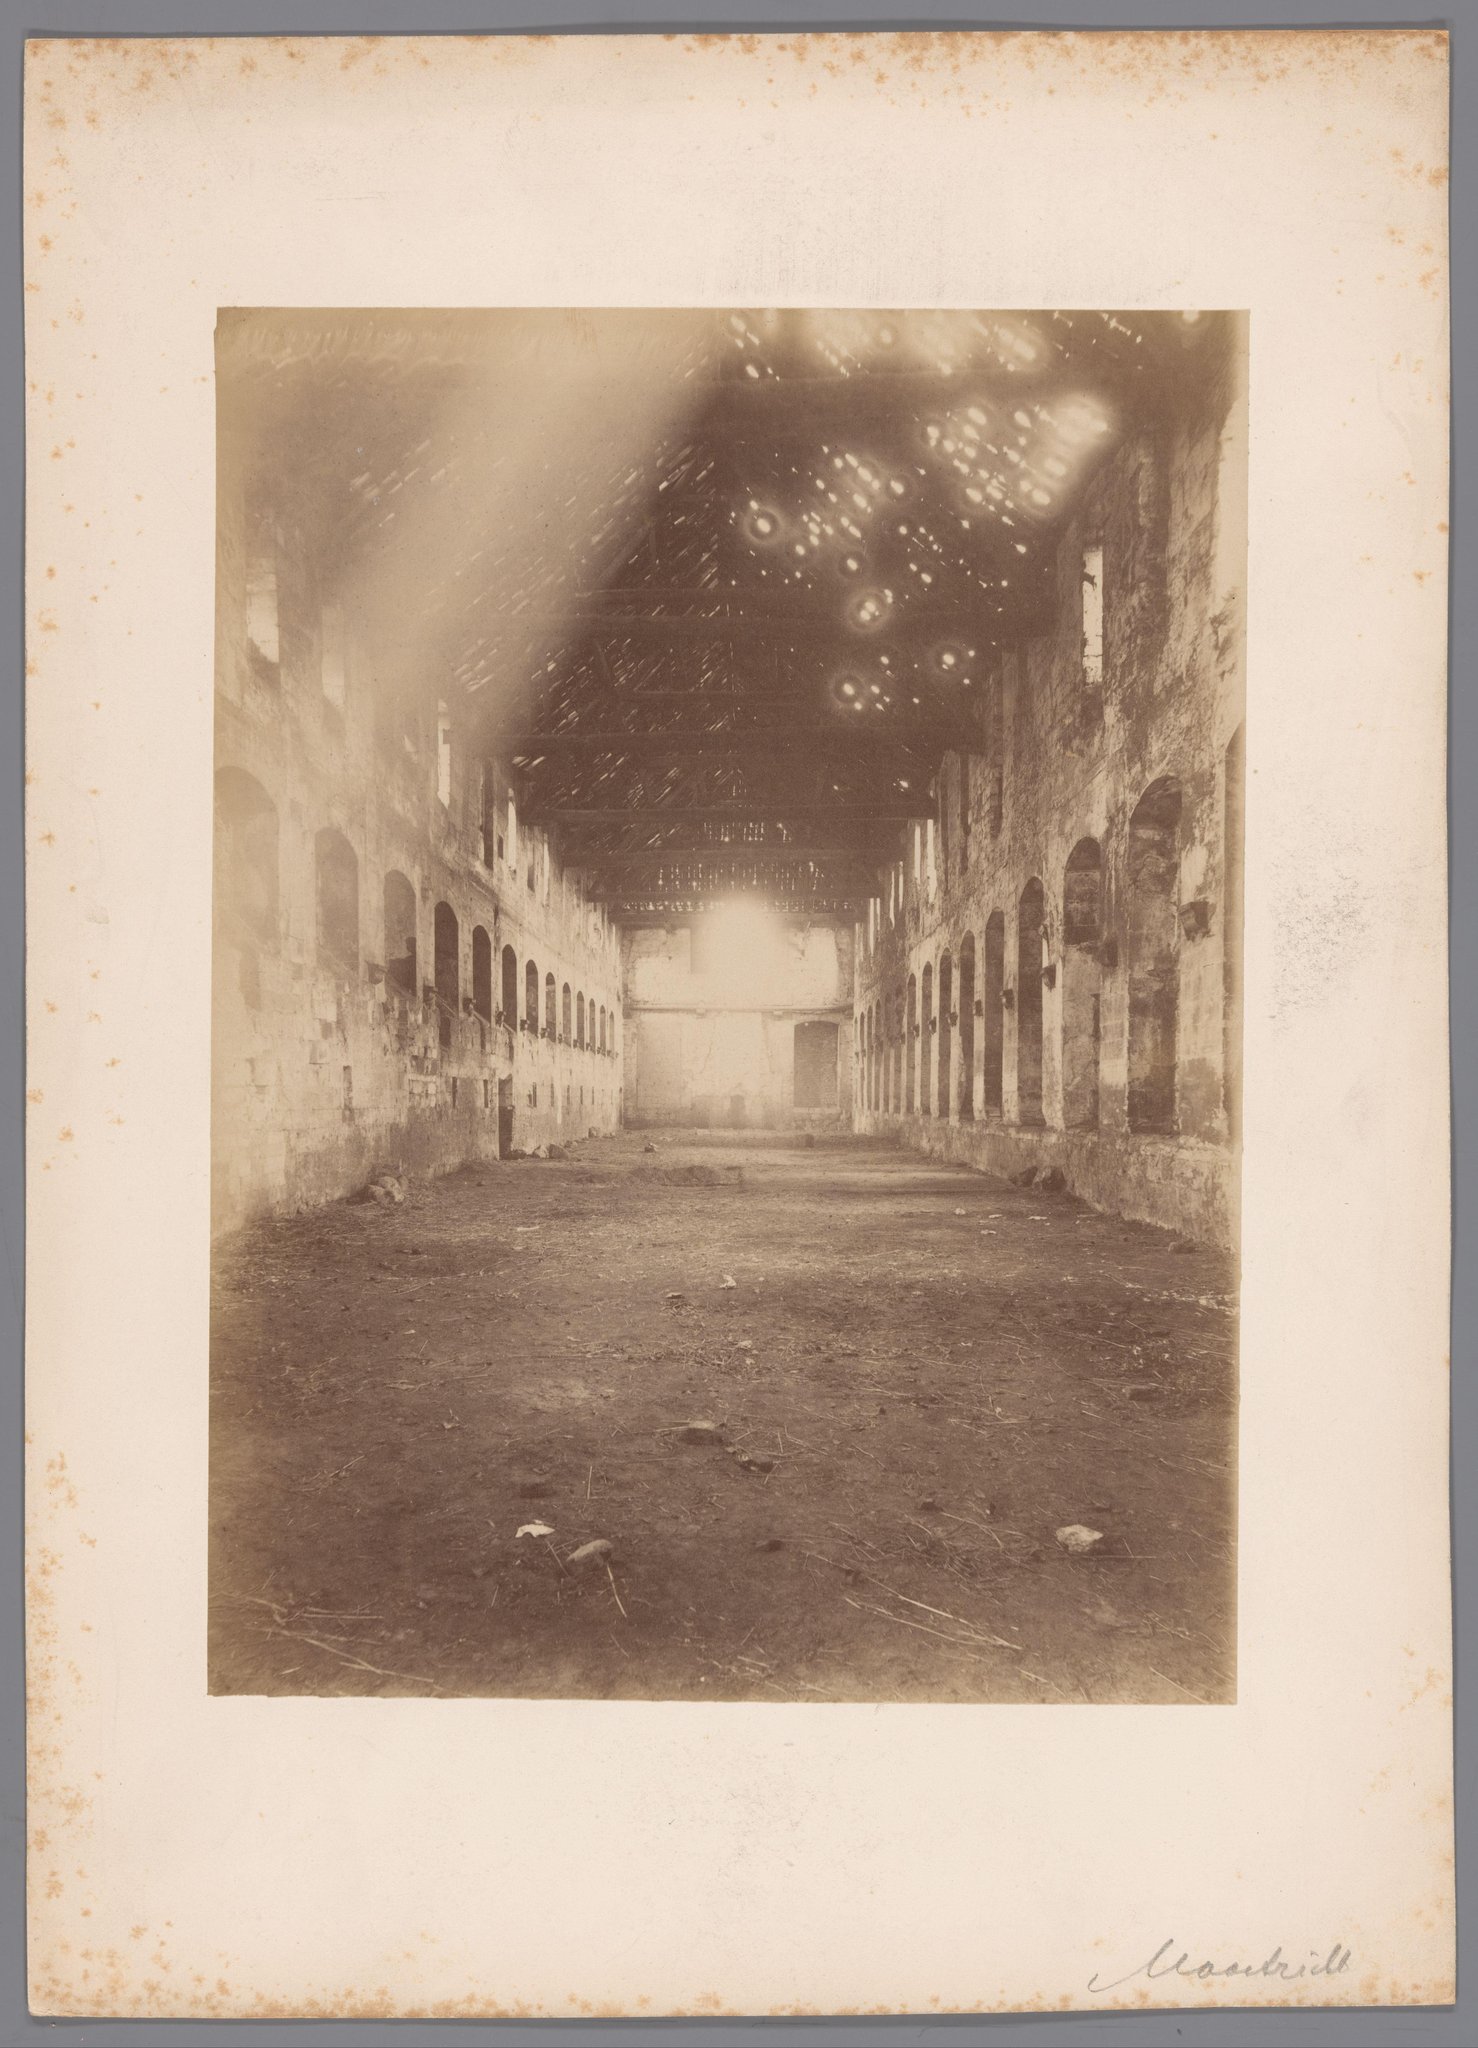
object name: photograph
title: Interieur van het oude Beyart klooster te Maastricht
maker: anoniem (monumentenzorg)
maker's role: fotograaf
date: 1893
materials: cardboard, photographic support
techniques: albumen print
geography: maastricht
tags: ruin of church, monastery, etc.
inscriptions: annotation: ‘Maastricht’, annotation: ‘Maastricht (L.)/ Beyaertgebouwen/ gezicht in een der ruimten van af het punt g./ Nov 1893’